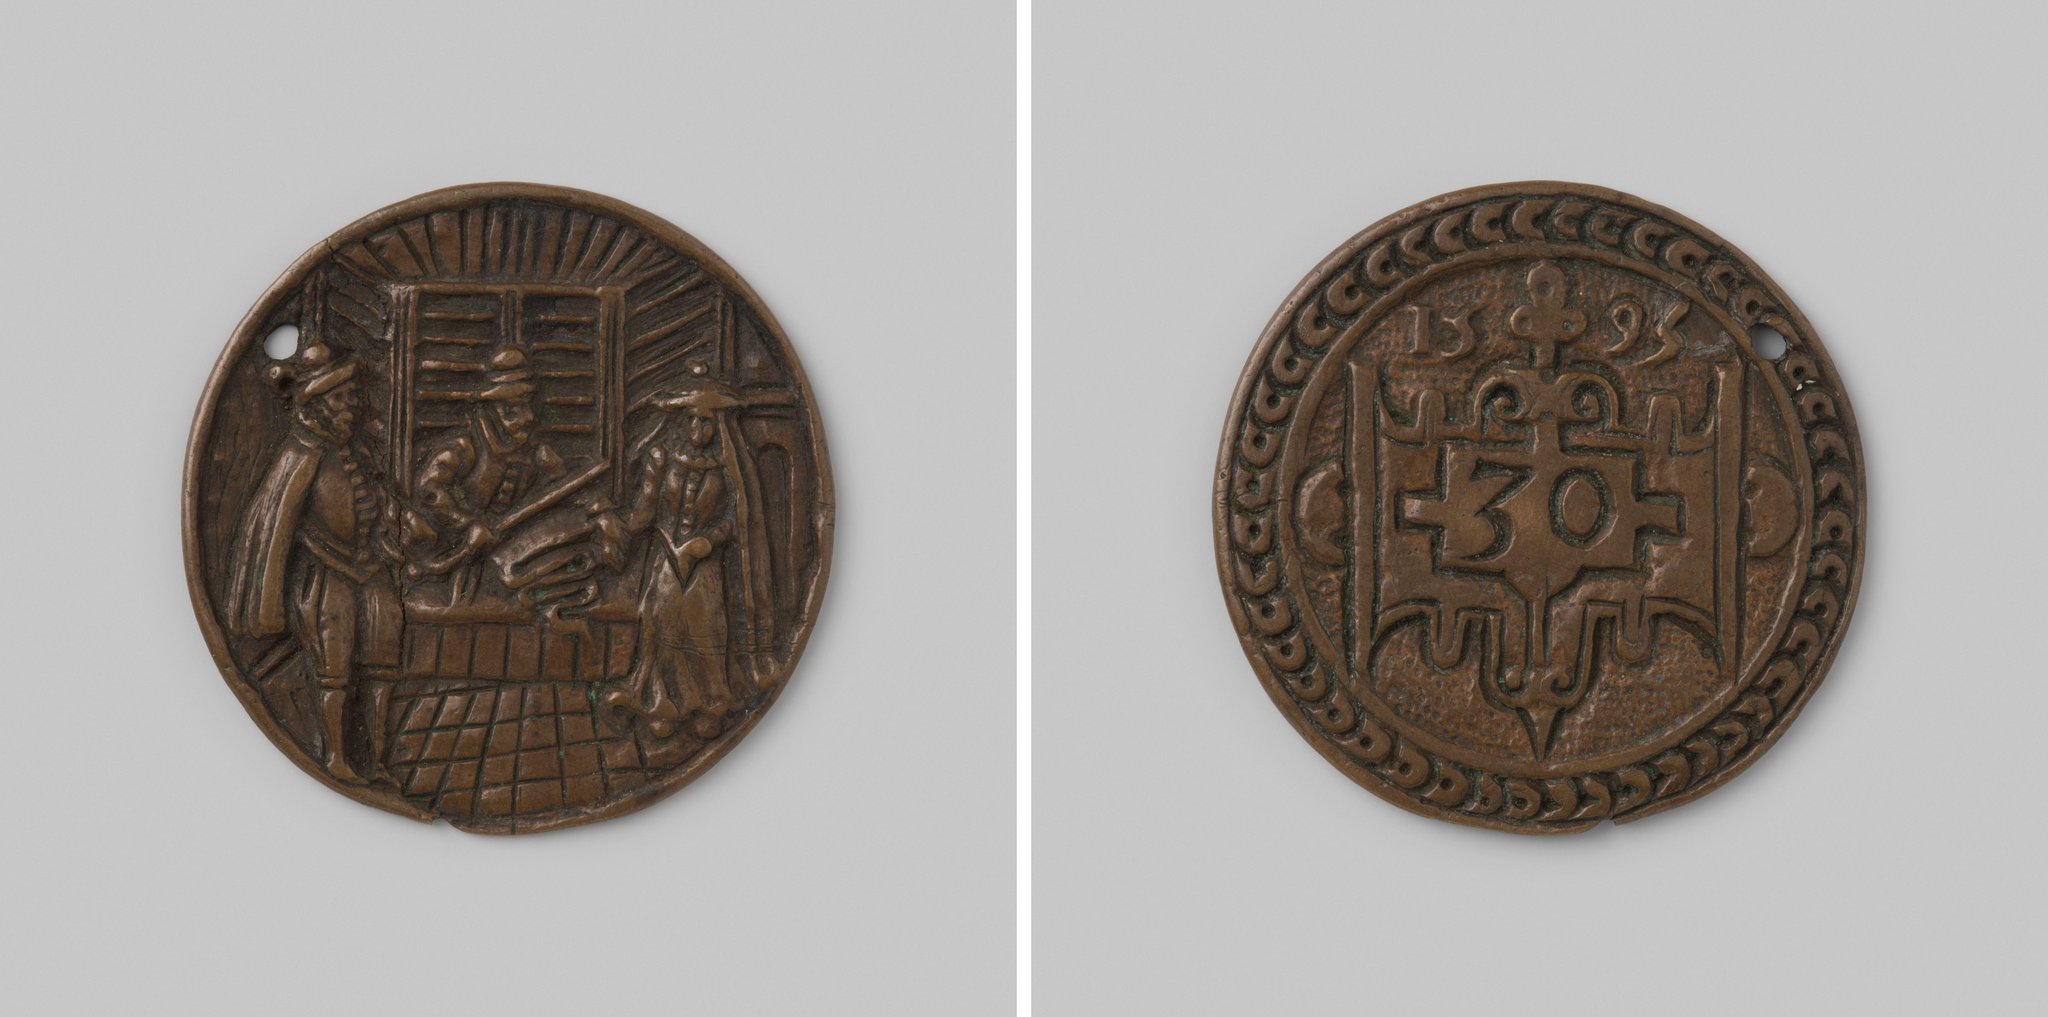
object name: medal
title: Presentiepenning van het Wollenlakerkopers en -snijdersgilde te Middelburg, 1595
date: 1595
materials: brass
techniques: casting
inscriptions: inscription: ‘30’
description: Gegoten messing penning, op de voorzijde het interieur van een lakenwinkel, op de keerzijde een gespvormig ornament waarop gegraveerd 30, onder het jaartal 1595, alles binnen een versierde rand, met gat